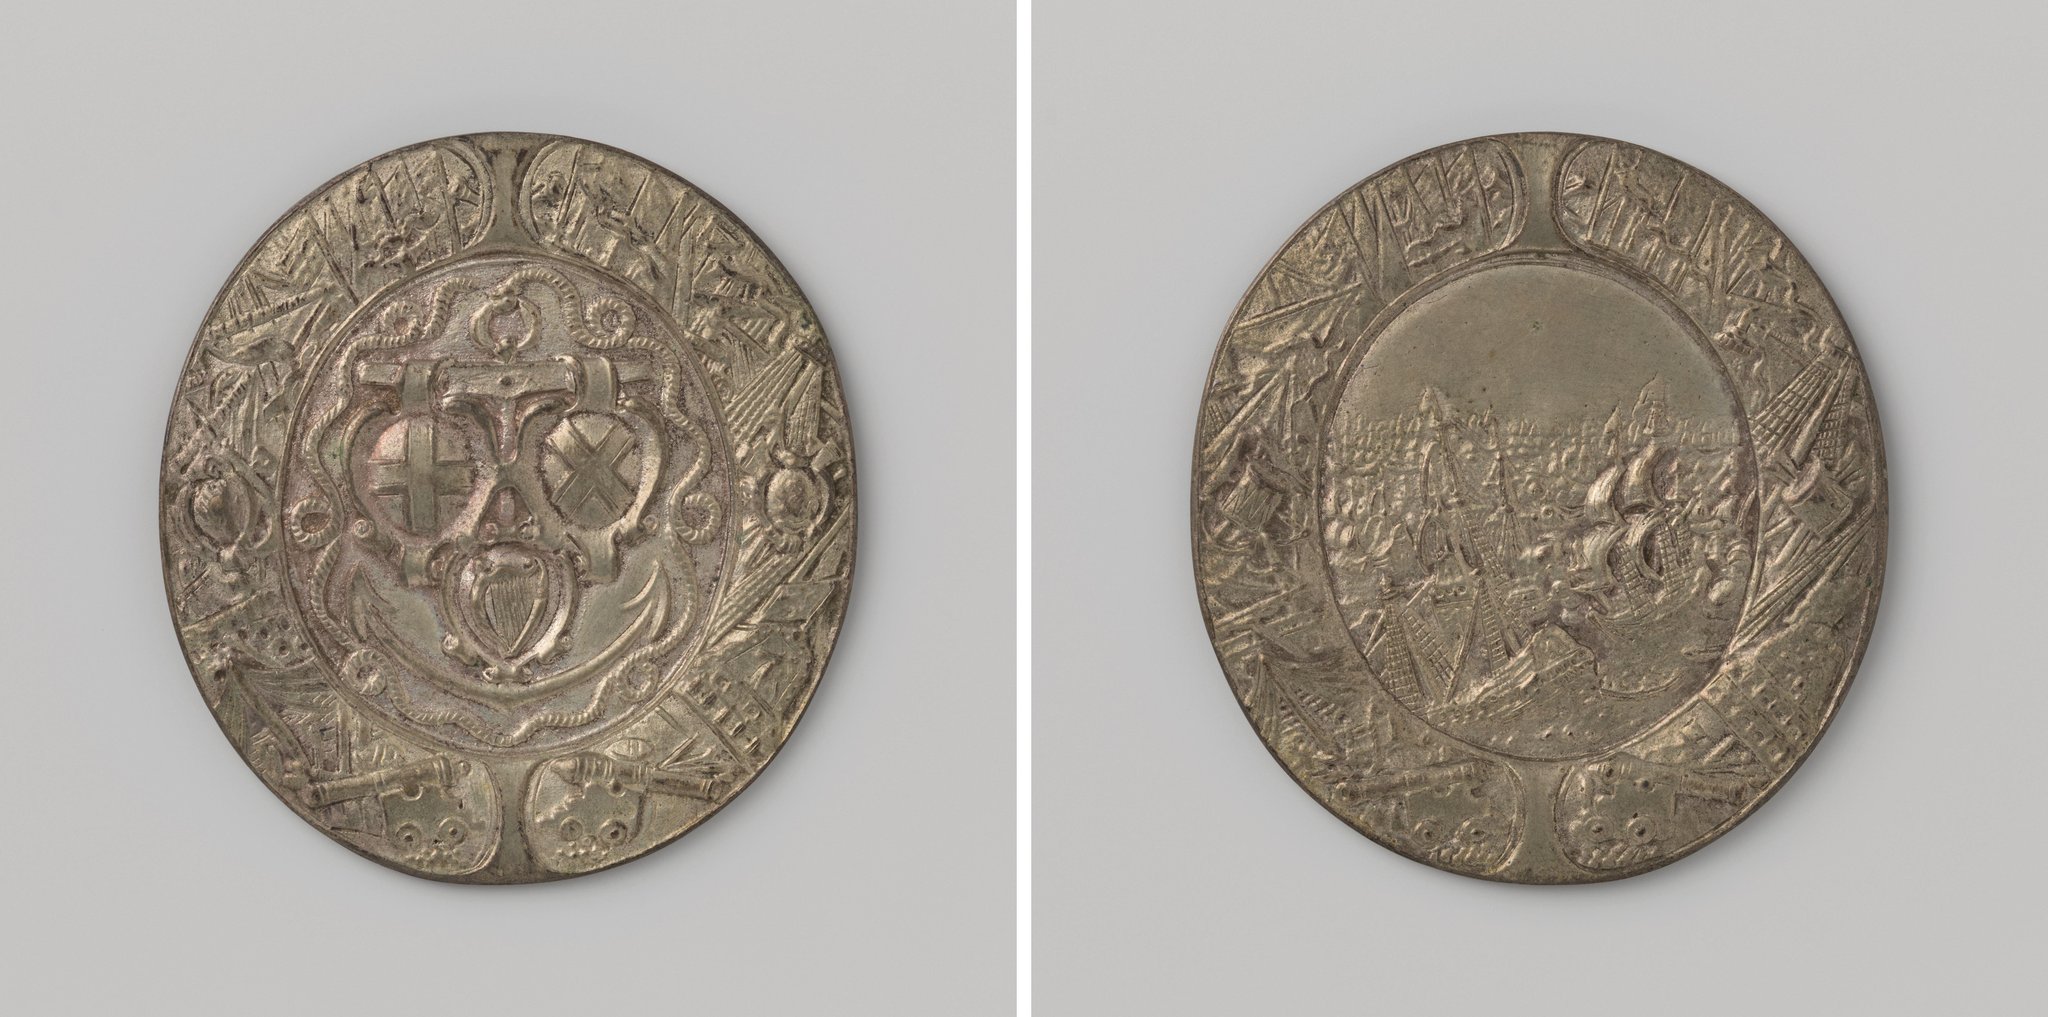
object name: honorary medal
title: Overwinningen op zee op de Nederlanders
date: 1653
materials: silver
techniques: striking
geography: london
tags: eerste engelse oorlog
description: Ovale zilveren penning. Voorzijde: drie wapenschilden, hangend aan anker binnen rand van scheepsgerei. Keerzijde: zeeslag binnen rand van scheepsgerei.